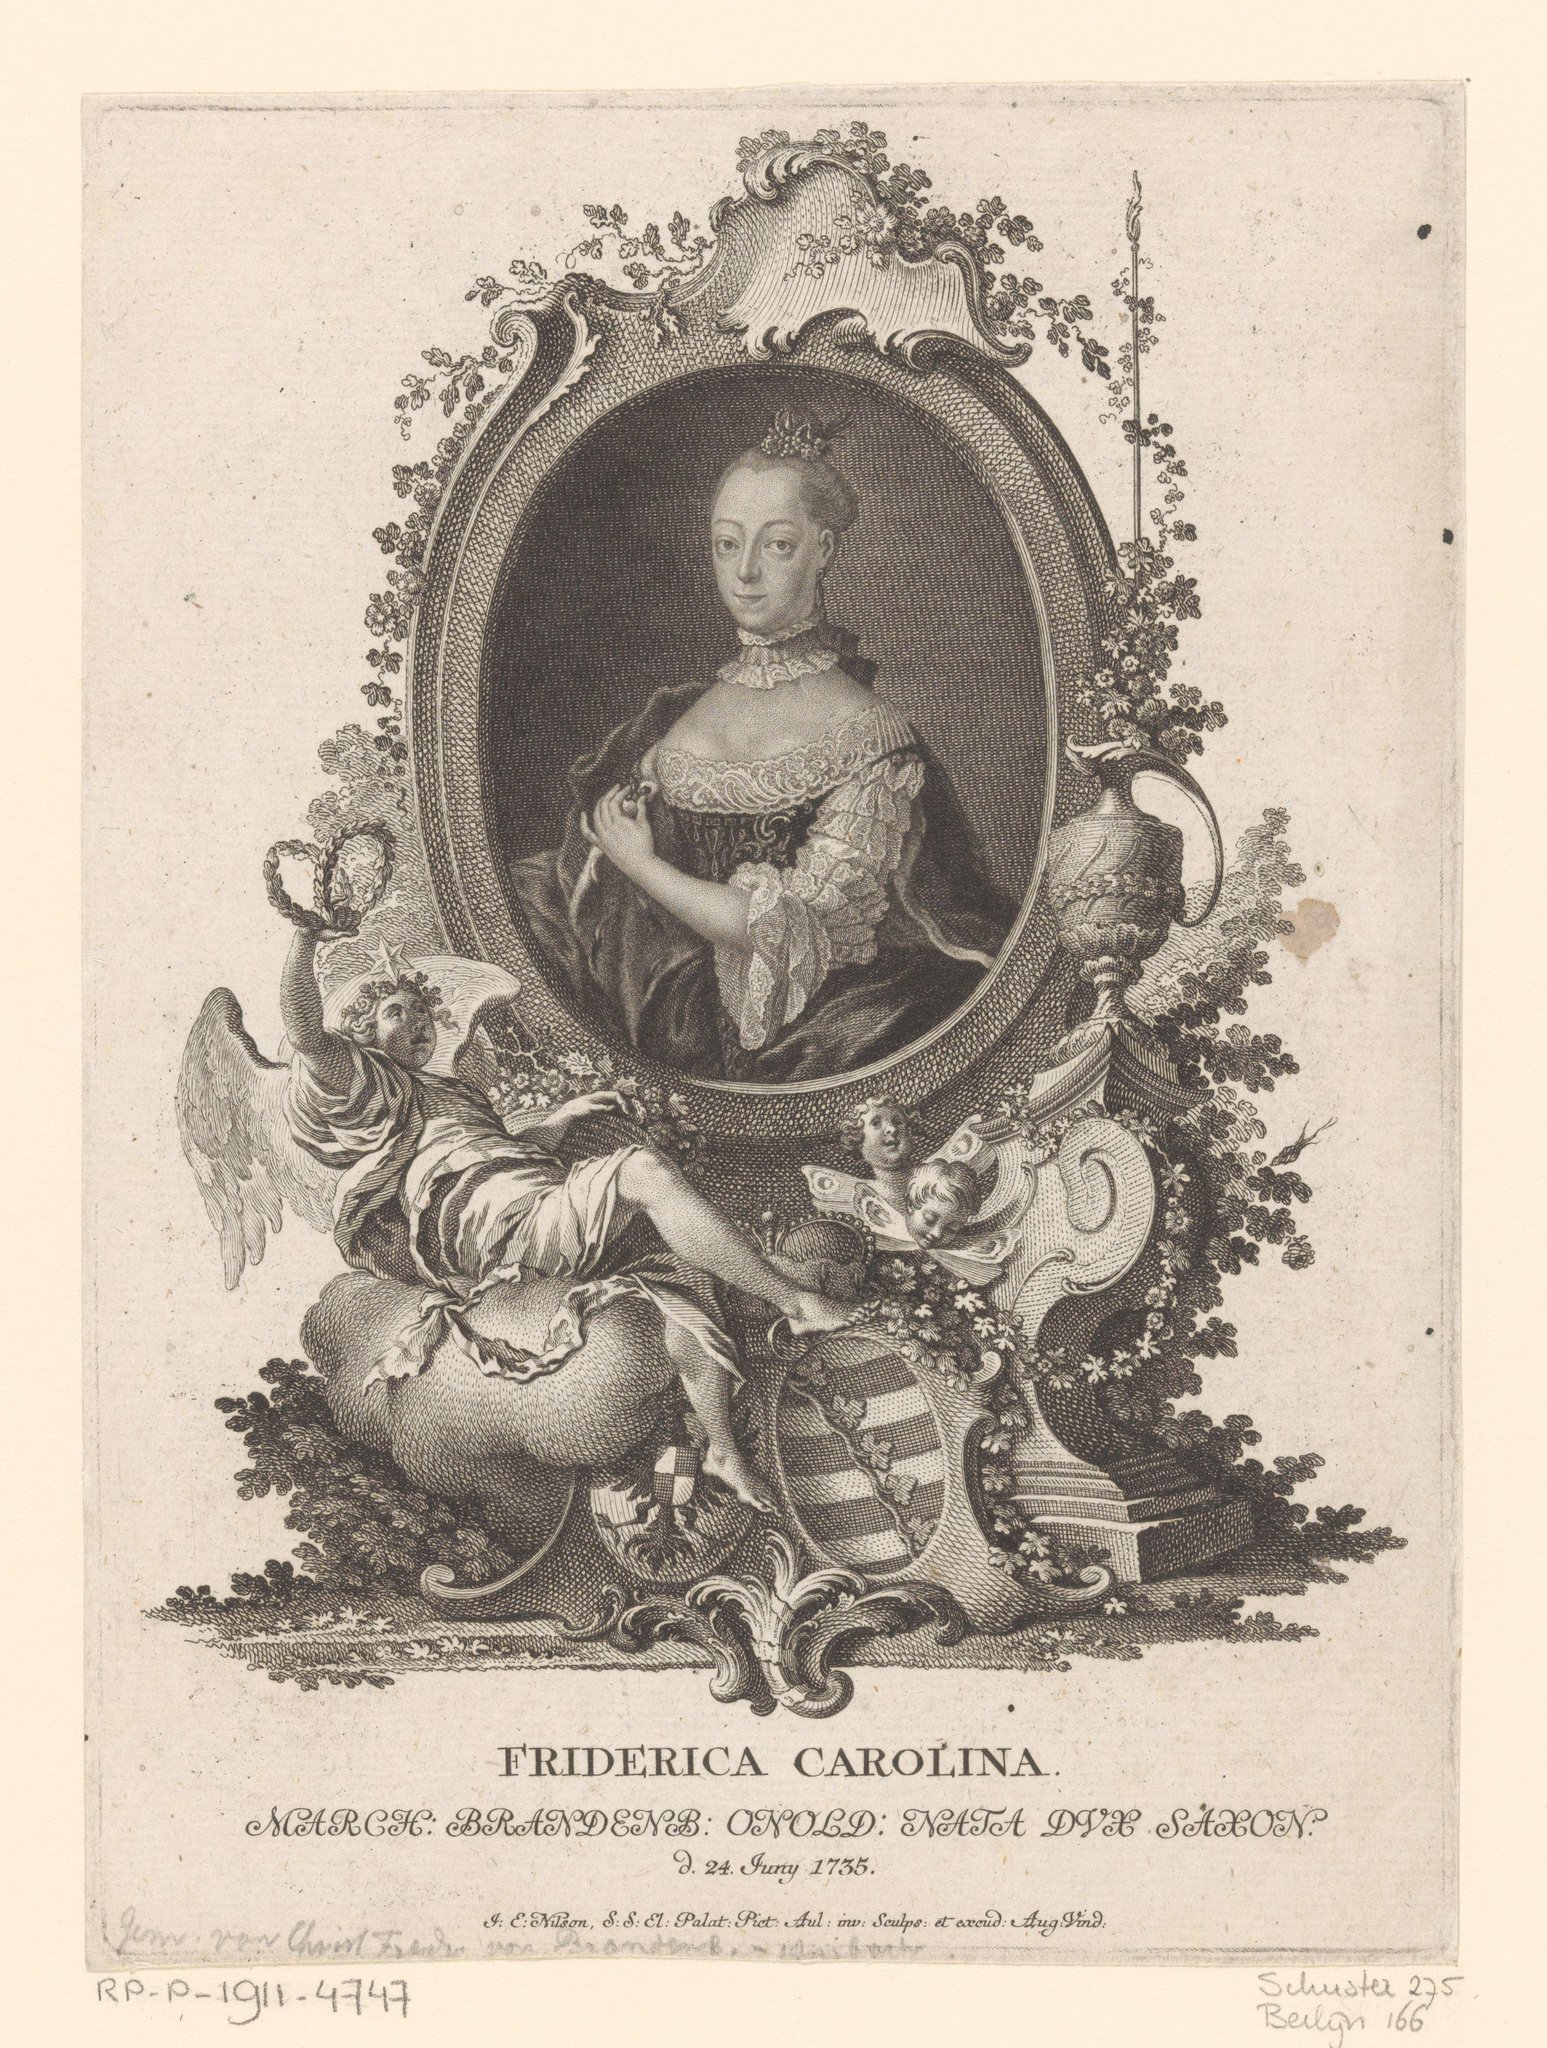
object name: print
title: Portret van Friederike Caroline von Sachsen-Coburg-Saalfeld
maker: johann esaias nilson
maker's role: draughtsman, print maker, publisher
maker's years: 1721-1788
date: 1754-1788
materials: paper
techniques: engraving, etching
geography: augsburg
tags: angels crowning and/or bringing palm-branches, historical persons, ruler, sovereign - bb - female ruler, armorial bearing, heraldry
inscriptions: collector's mark: Lugt 2228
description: Portret van Friederike Caroline von Sachsen-Coburg-Saalfeld, markgravin van Brandenburg, in een rocaille omlijsting. Daaronder zit een engel met een ster op het hoofd en twee kransen in de hand naast twee wapenschilden en een vaas.